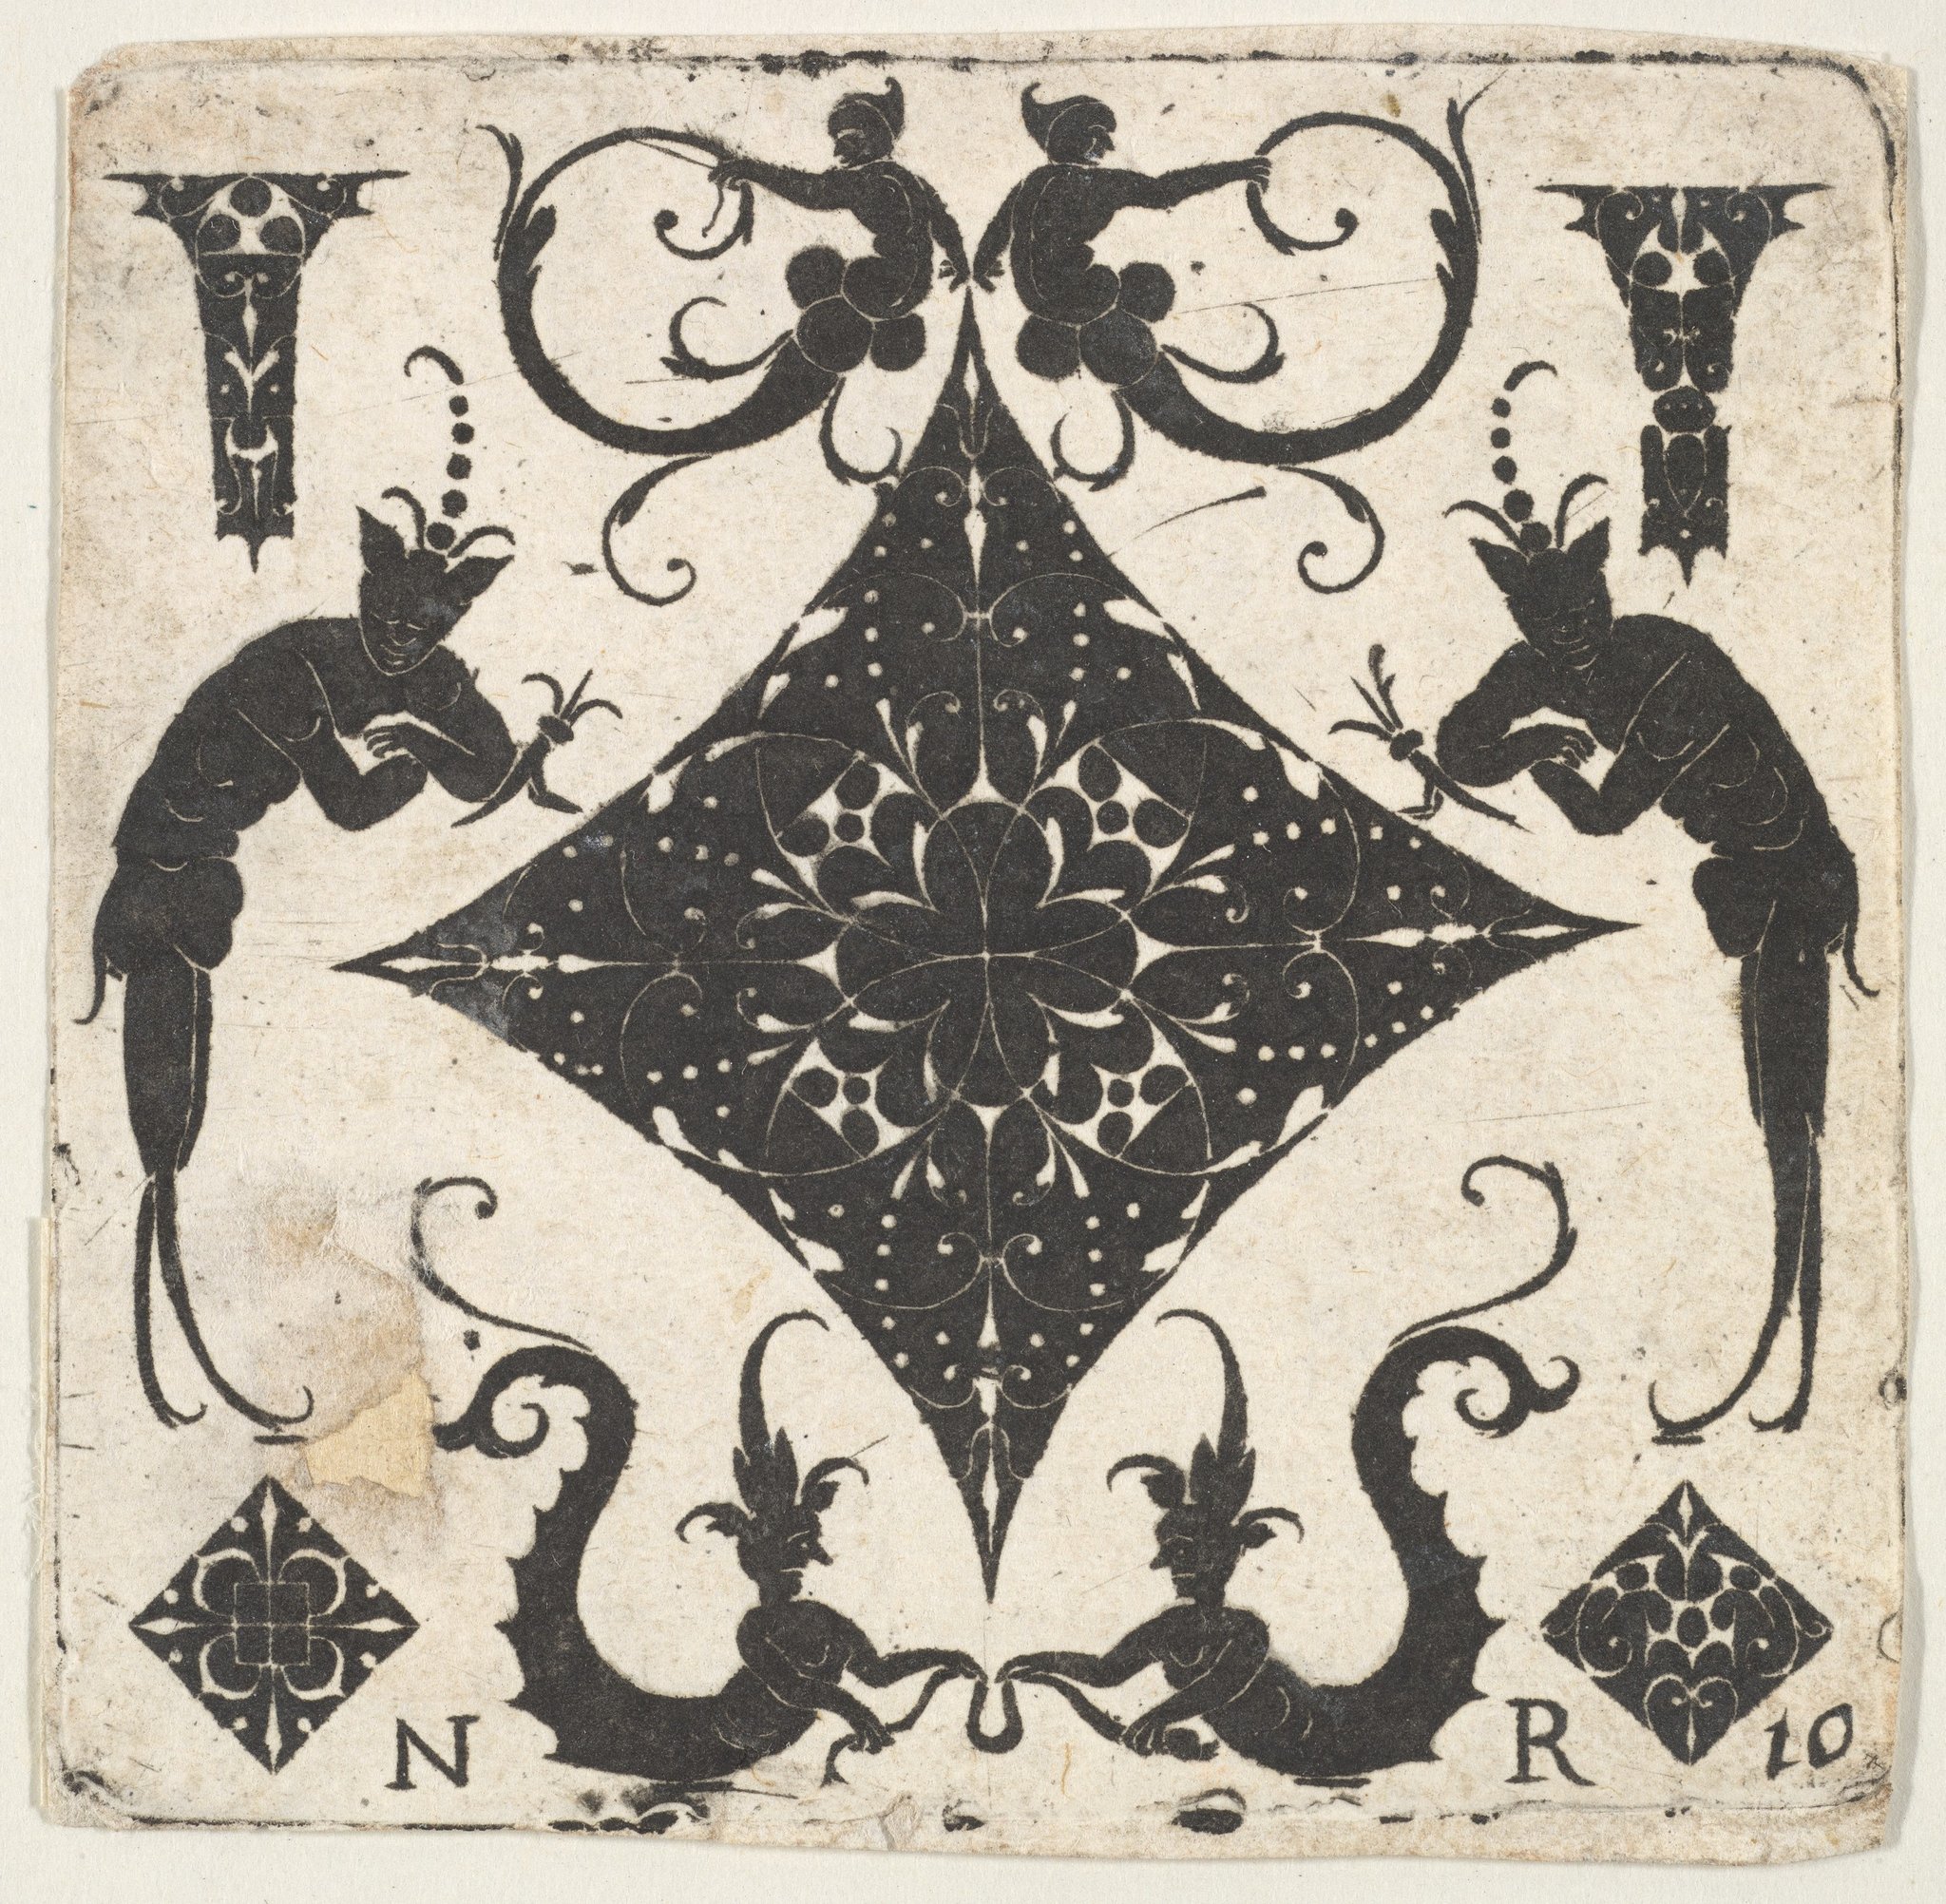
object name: print collection ornament architecture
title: Concave Lozenge-shaped Panel and Grotesque Figures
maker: noël rouillard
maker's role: printmaker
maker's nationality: french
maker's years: 1589-1646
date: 1620-1630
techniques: embroidery, engraving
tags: grotesques,ornament,mythical creatures